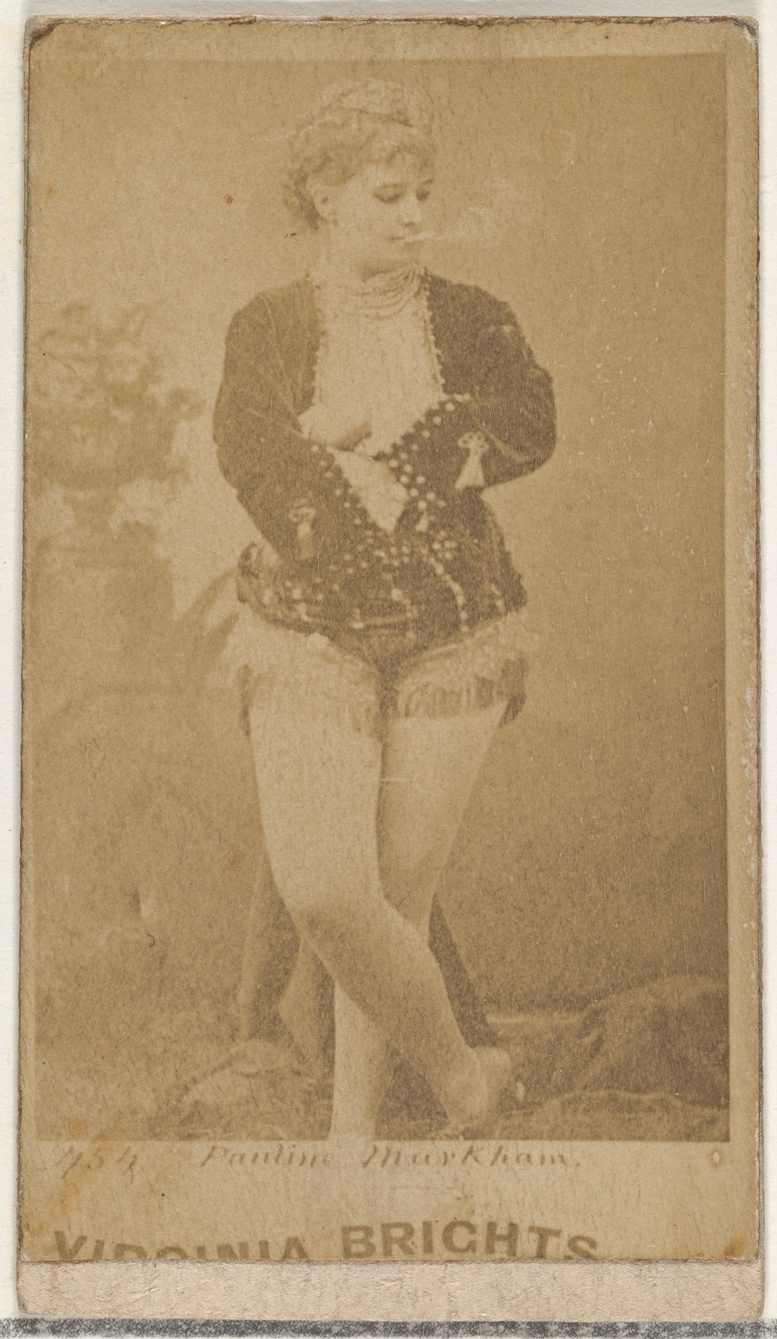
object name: photograph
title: Card 454, Pauline Markham, from the Actors and Actresses series (N45, Type 1) for Virginia Brights Cigarettes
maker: allen & ginter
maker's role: publisher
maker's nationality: american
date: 1888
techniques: albumen silver print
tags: portraits,women,smoking,actresses